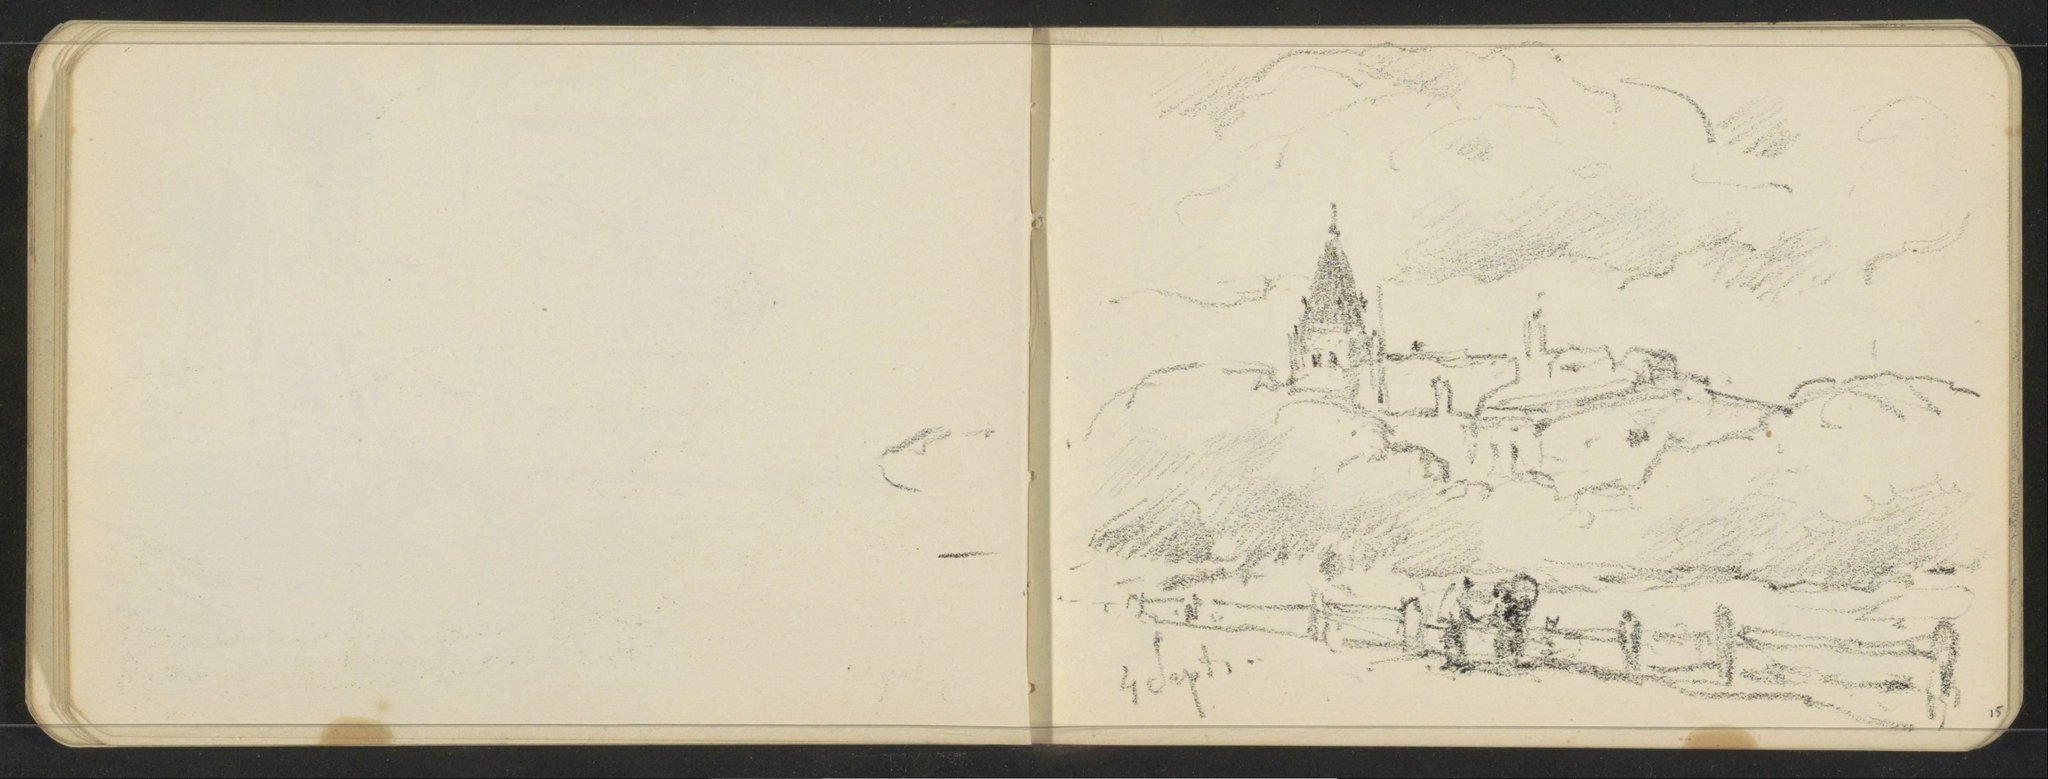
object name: sketchbook leaf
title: Gebouw met een toren aan een waterkant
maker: willem cornelis rip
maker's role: draughtsman, painter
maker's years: 1856-1922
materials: chalk, paper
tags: fence, wall, paling, landscapes with waters, waterscapes, seascapes (in the temperate zone), city-view, and landscape with man-made constructions (+ city(-scape) with figures, staffage)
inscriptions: date: ‘4 Sept.’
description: Op de voorgrond staan twee figuren bij een hek aan het water. Blad 14 verso en 15 recto uit een schetsboek met 41 bladen.